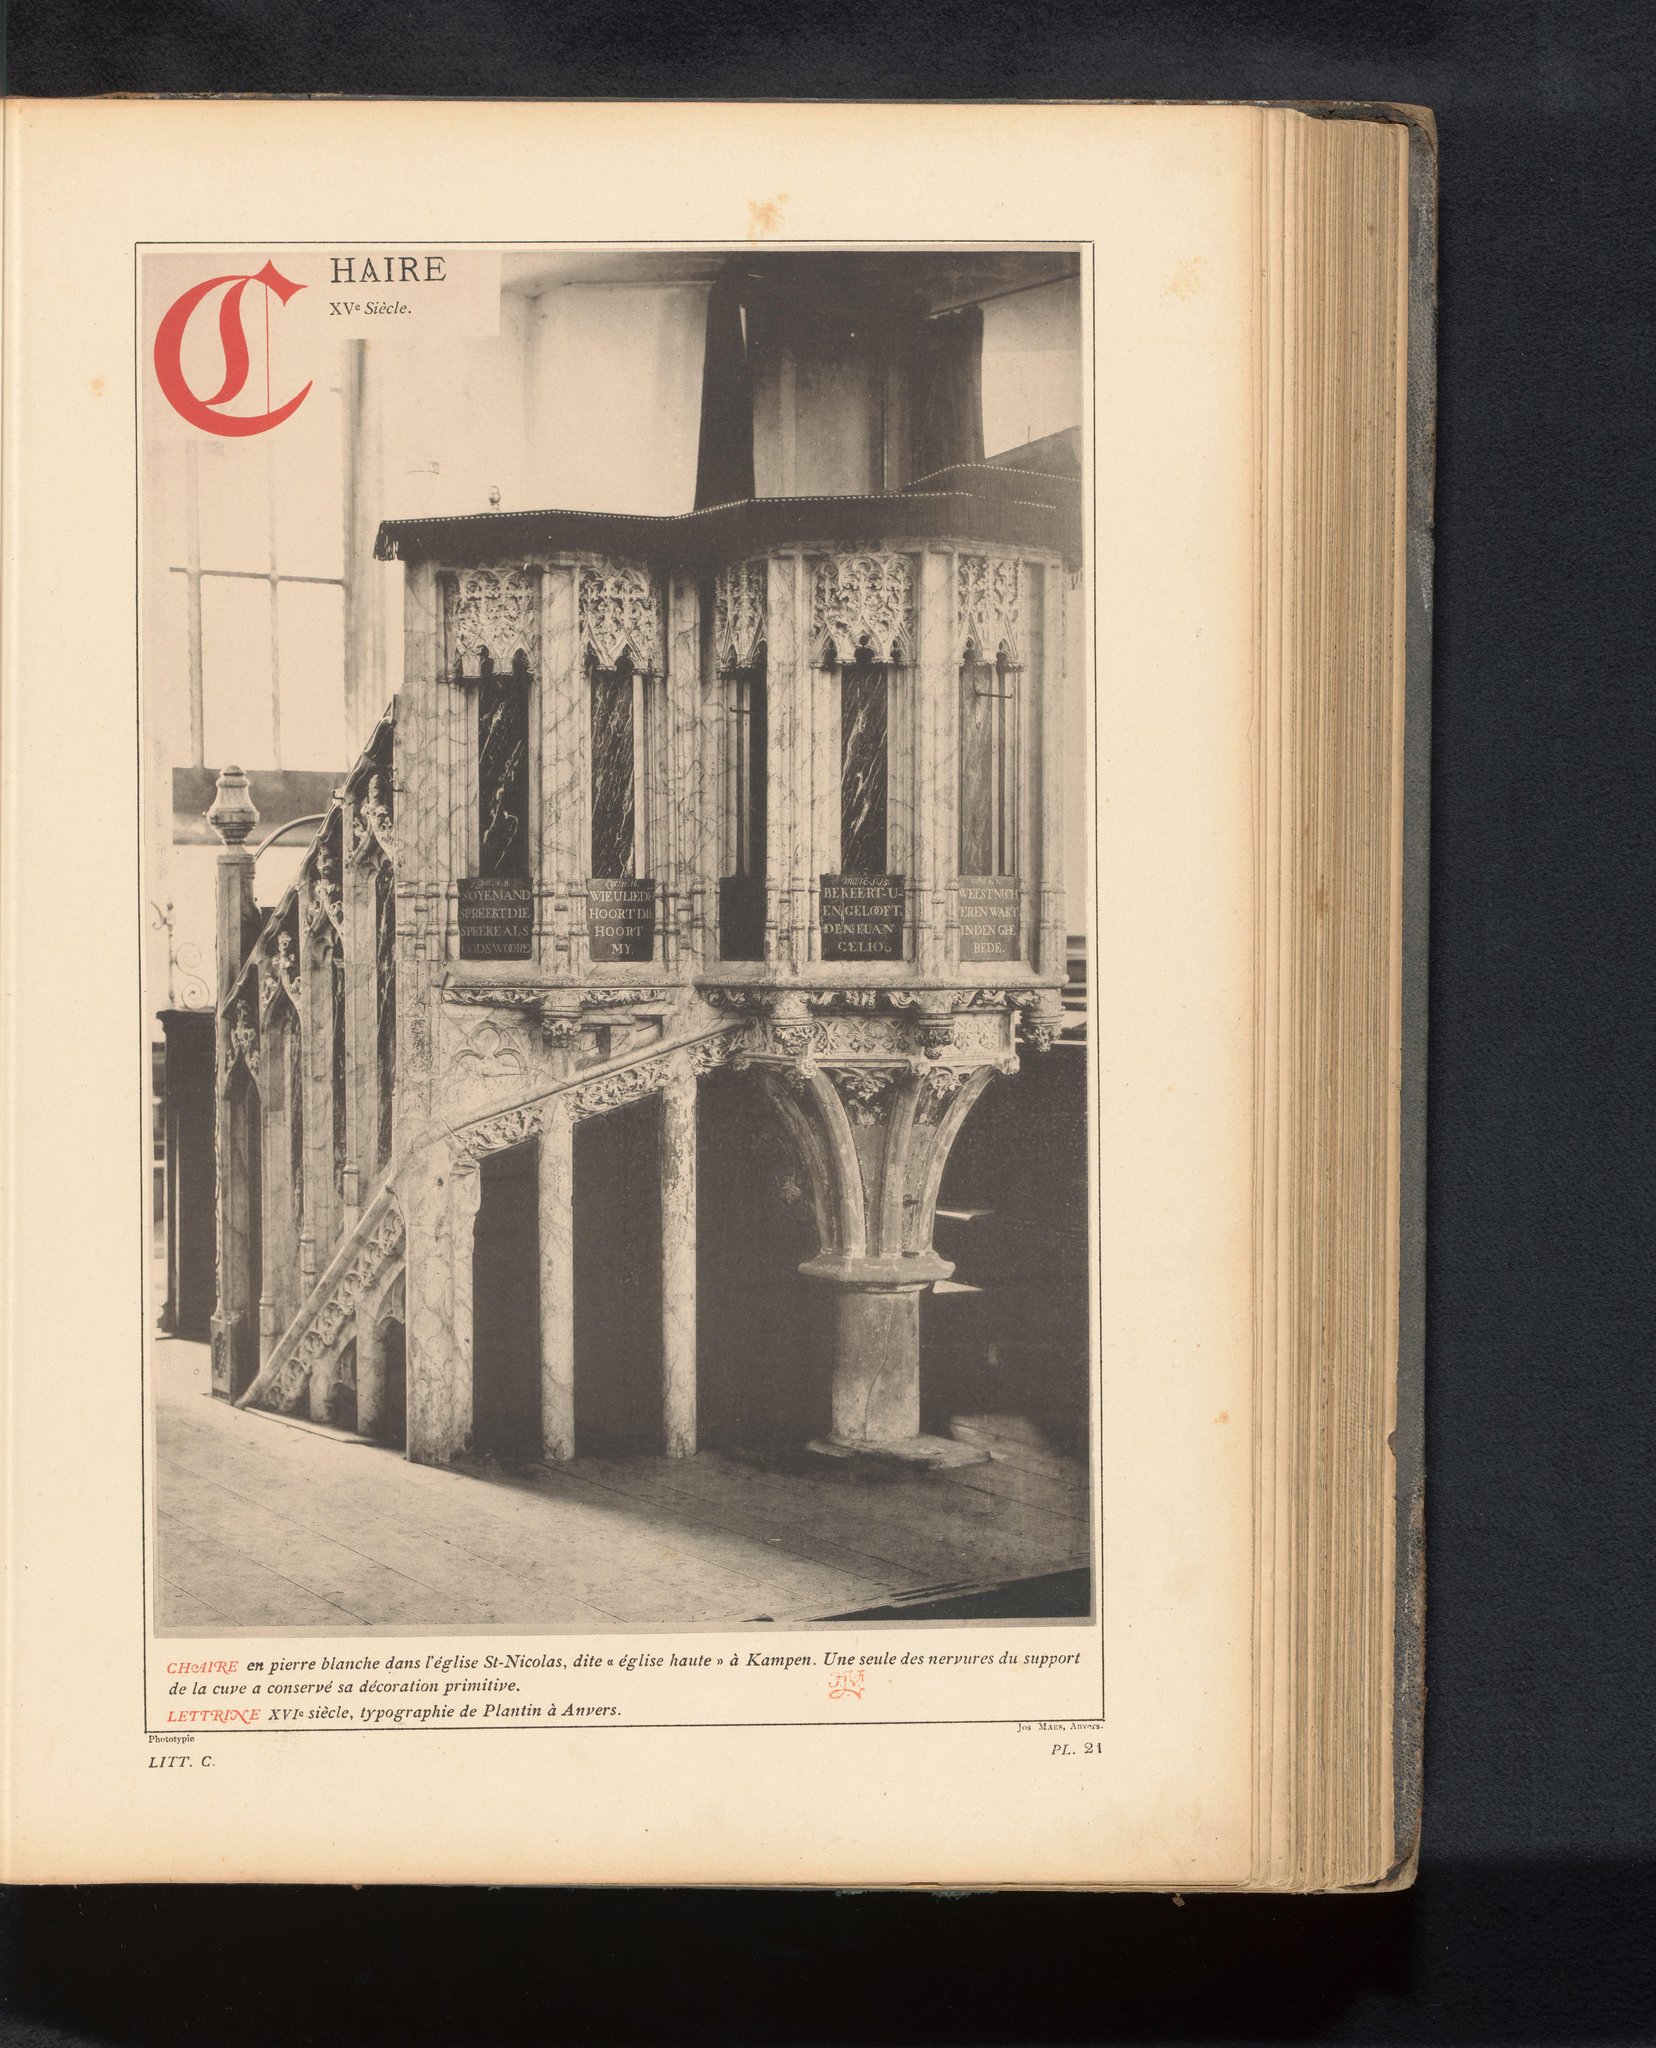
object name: page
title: Chaire, XVe Siècle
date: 1875-1880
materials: paper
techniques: photograph, photolithography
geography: antwerp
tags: pulpit, ambo, chancel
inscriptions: monogram: ‘JJvY’, inscription: ‘Chaire en pierre (...)’, inscription: ‘LITT. C. - PL. 21’